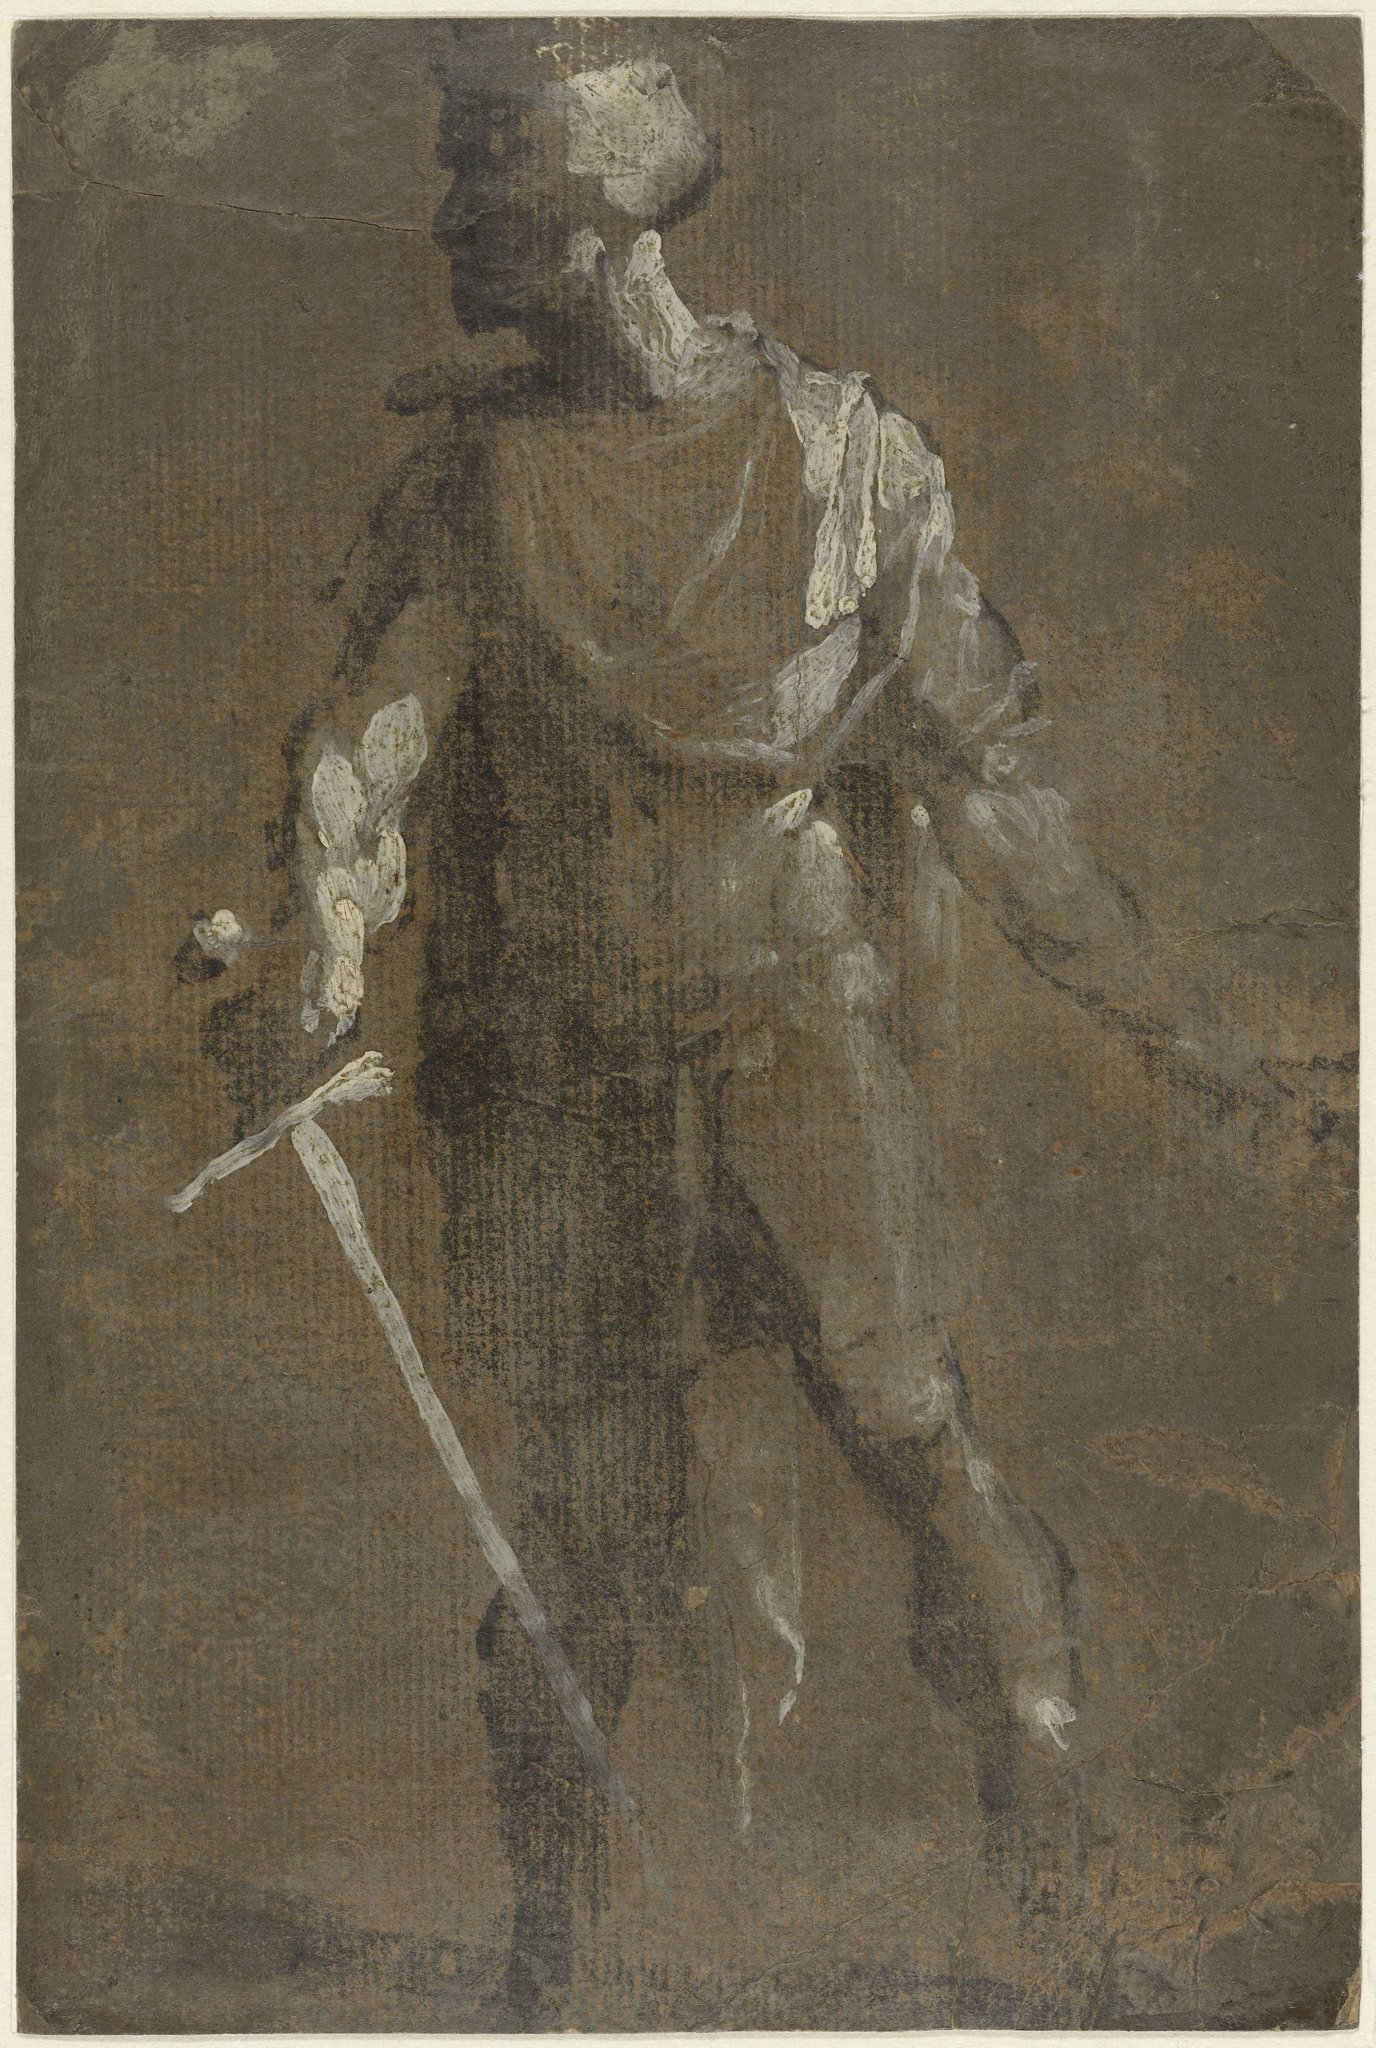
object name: drawing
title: Scherprechter Servilius Ahala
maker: domenico beccafumi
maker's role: draughtsman, painter, print maker, sculptor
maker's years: 1486-1551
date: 1530-1535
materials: paper, paint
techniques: varnishing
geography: siena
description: Voorstudie voor fresco; studie voor de scherprechter Servilius in de schildering van de dood van Spurius Maelius.